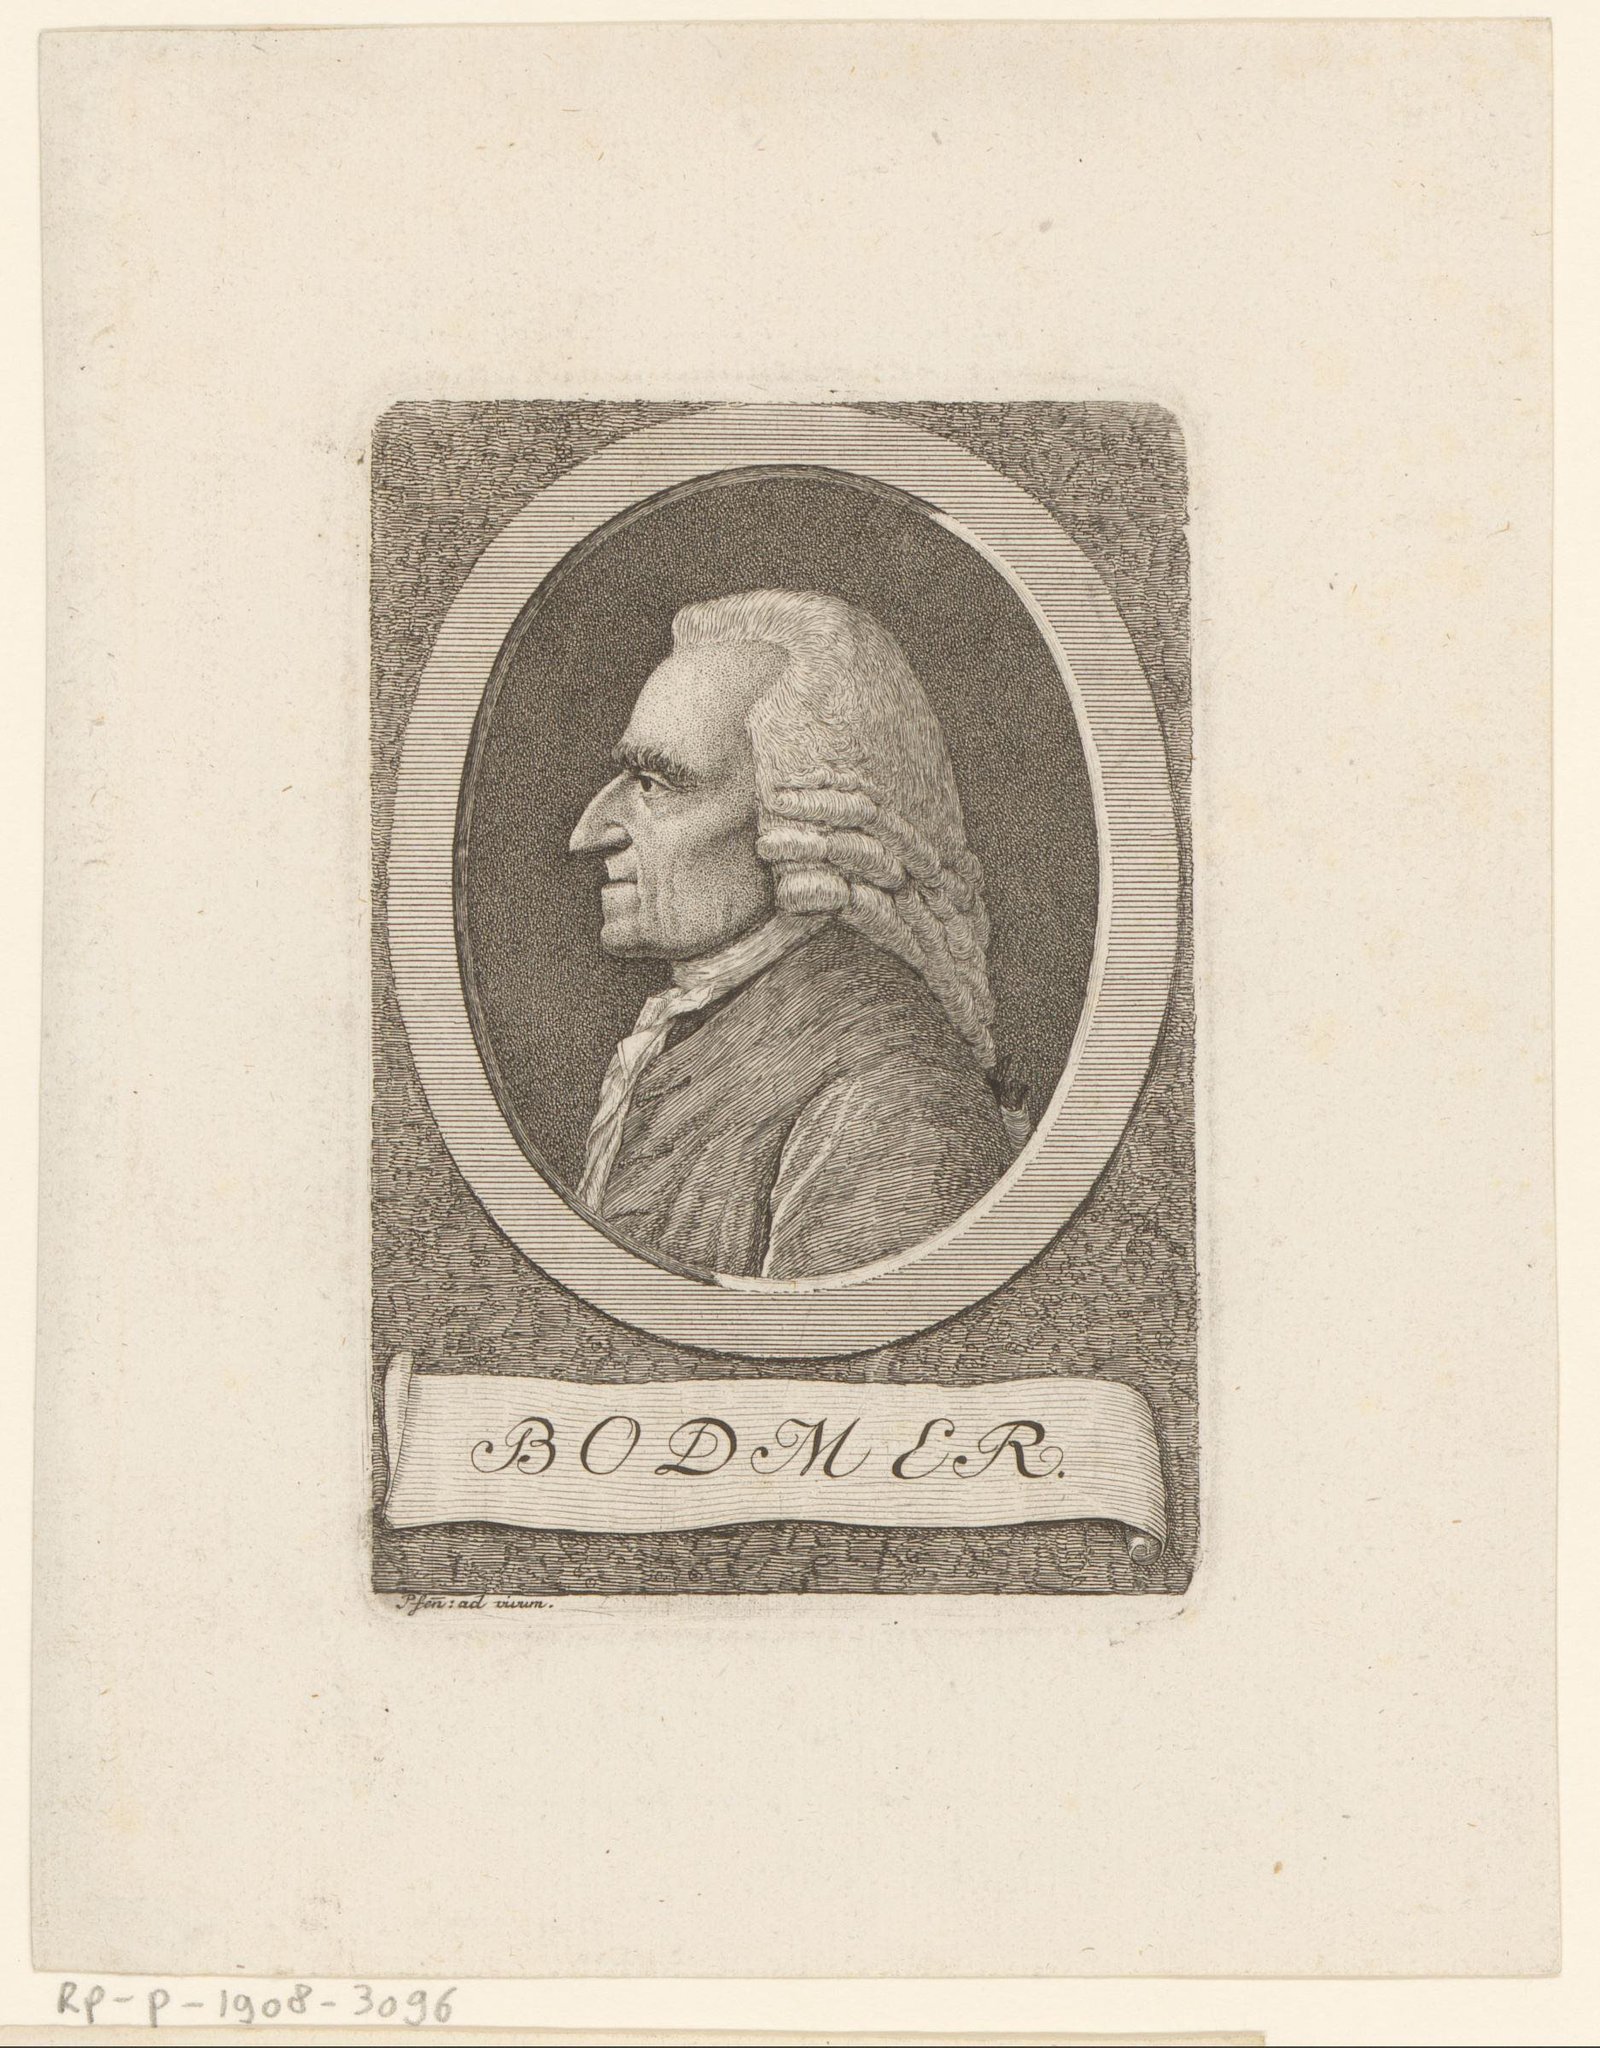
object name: print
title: Portret van Johann Jacob Bodmer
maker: heinrich pfenninger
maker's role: print maker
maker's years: 1749-1815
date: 1759-1815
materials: paper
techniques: etching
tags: historical persons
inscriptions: collector's mark: Lugt 2228